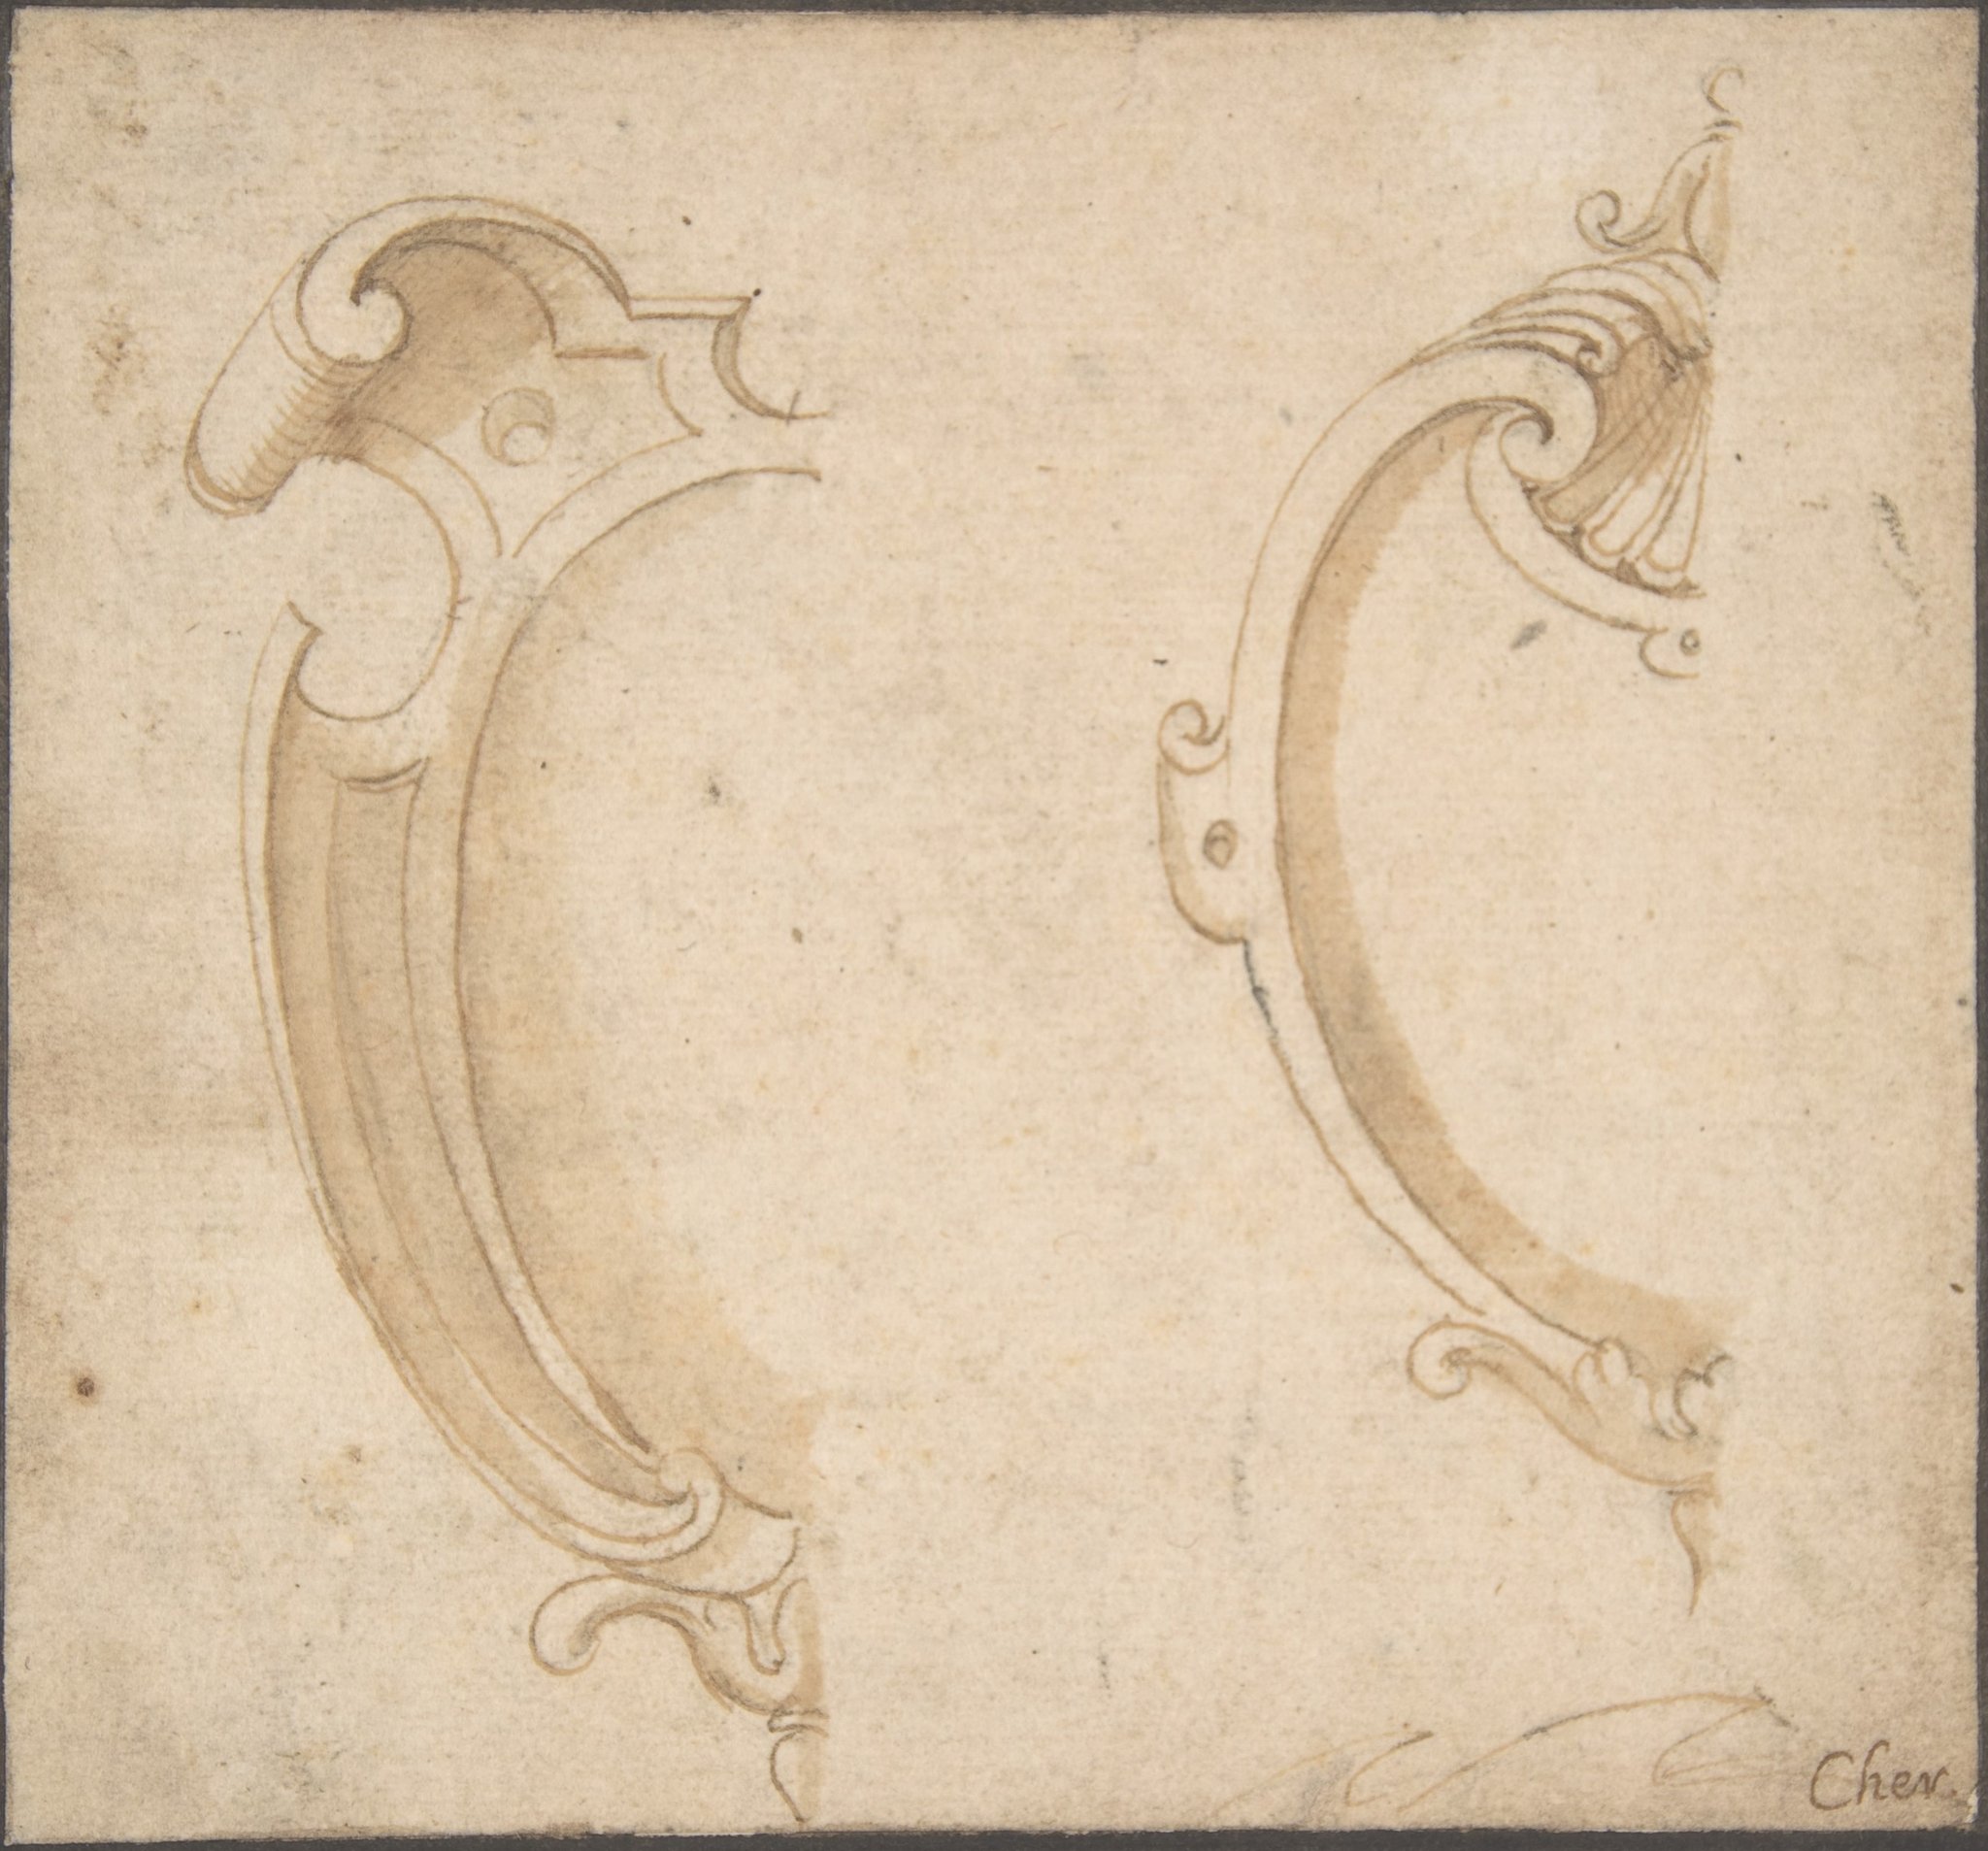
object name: drawing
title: Design for Two Cartouches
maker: anonymous, french, 16th century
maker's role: artist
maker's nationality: french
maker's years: 1500-1600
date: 1501-1600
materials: ink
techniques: brush, pen, wash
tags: cartouches